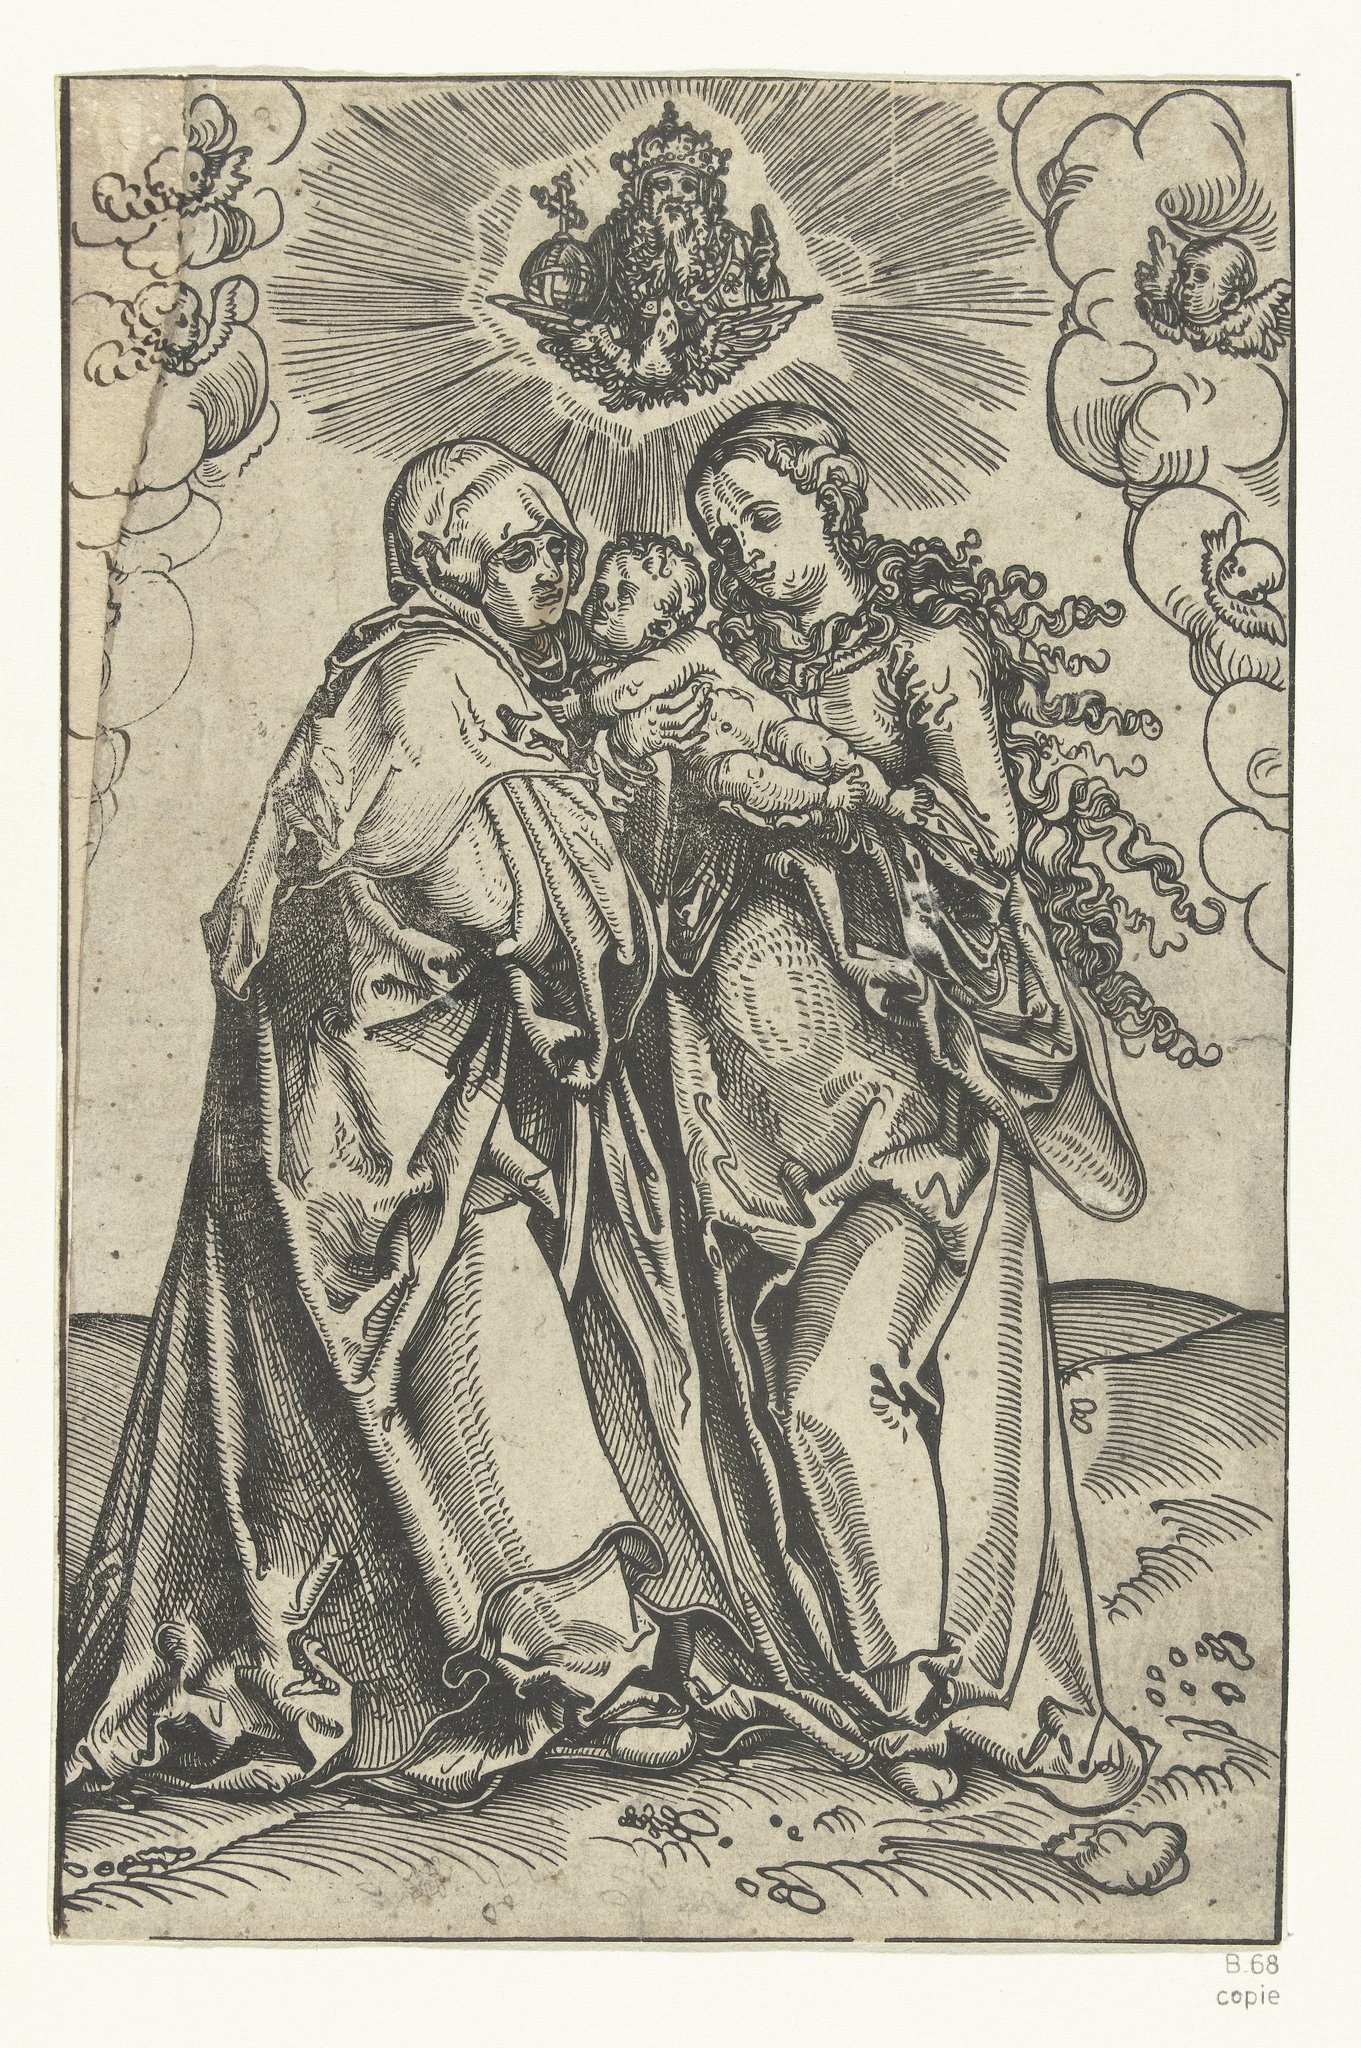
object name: kopie naar prent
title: Maria met Kind en Heilige Anna en Drieëenheid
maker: Anonymous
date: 1482-1603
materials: paper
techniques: woodcut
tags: 'anna selbdritt', i.e. anna, mary and christ-child close together, the holy trinity, 'trinitas coelestis'; father, son and holy ghost ~ christian religion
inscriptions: collector's mark: Lugt 240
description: Anna te Drieën: staande Maria overhandigt het Christuskind aan de naast haar staande Heilige Anna. Boven hun hoofden verschijnt in een stralenkrans God de Vader met een wereldbol en de Heilige Geest, verbeeld als een duif. Samen met het Christuskind vormen zij de Drieëenheid.